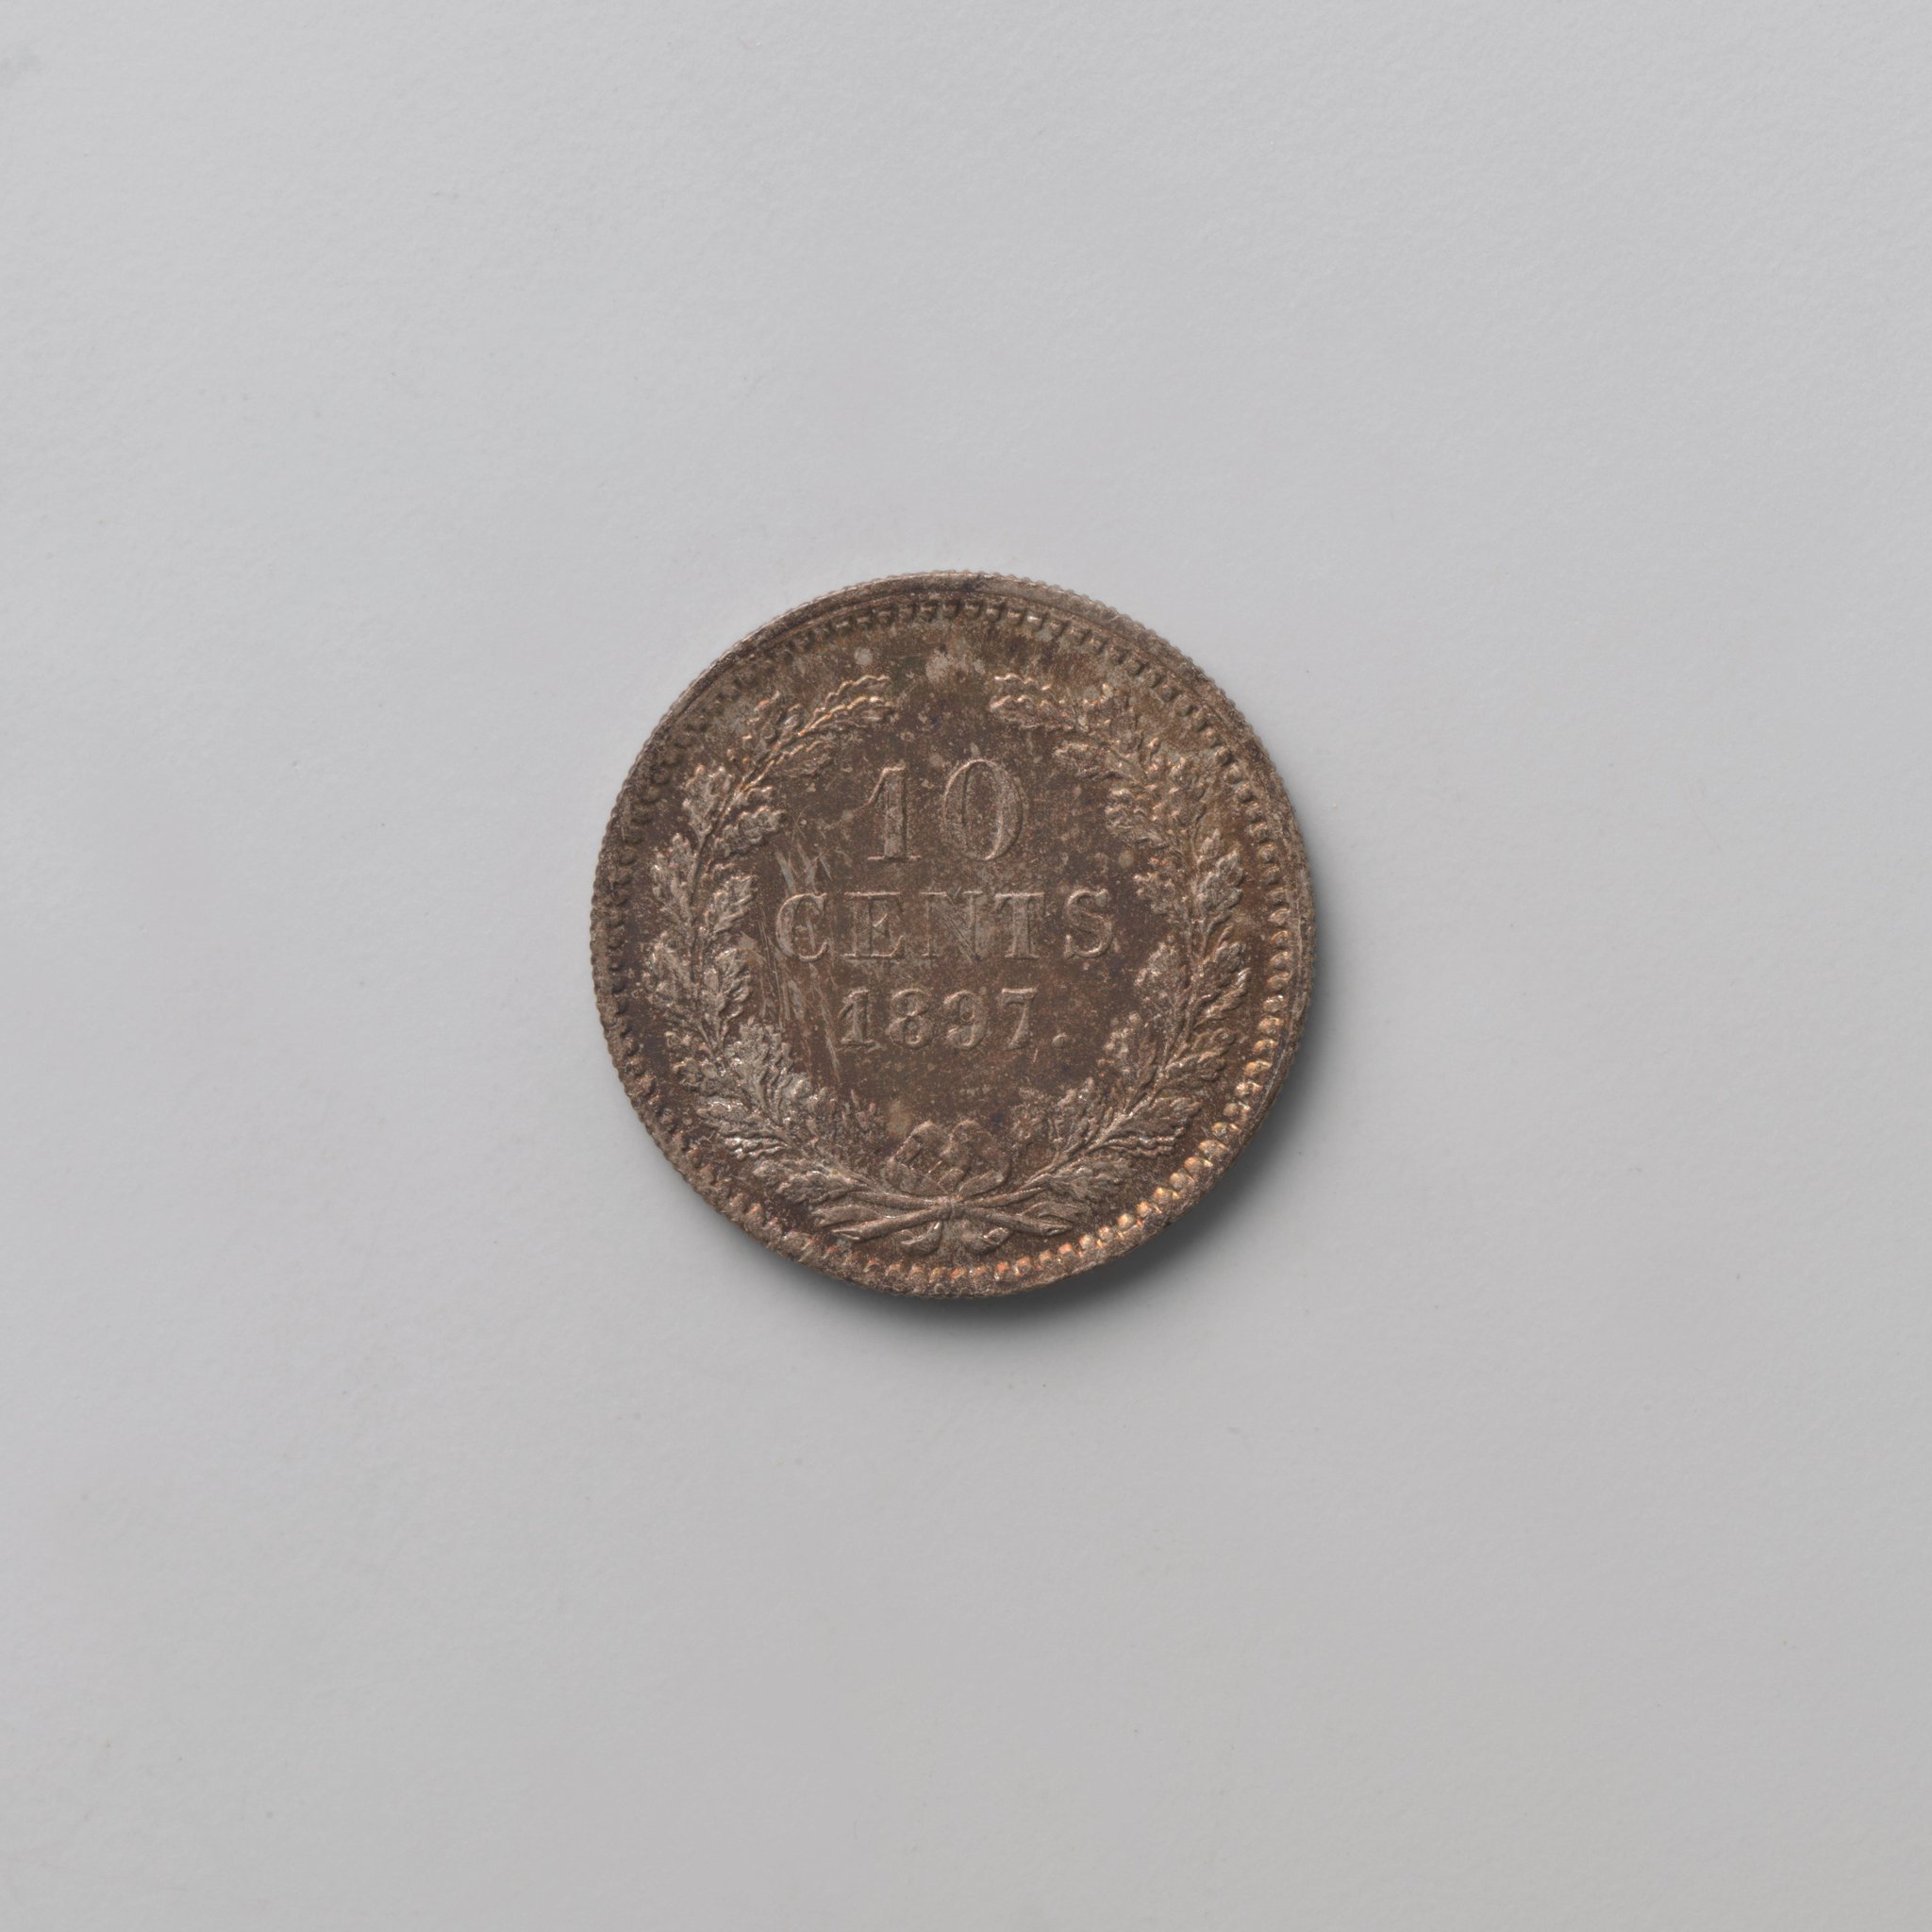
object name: coin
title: Nederland,10 cent,1897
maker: wilhelmina of the netherlands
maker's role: print maker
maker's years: 1880-1962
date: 1897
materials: silver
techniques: striking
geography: utrecht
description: Zilveren munt. Voorzijde: jeugdig borstbeeld naar links. Keerzijde: binnen twee samengebonden eiketakken waarde-aanduiding 10 cents en jaartal. Kartelrand.